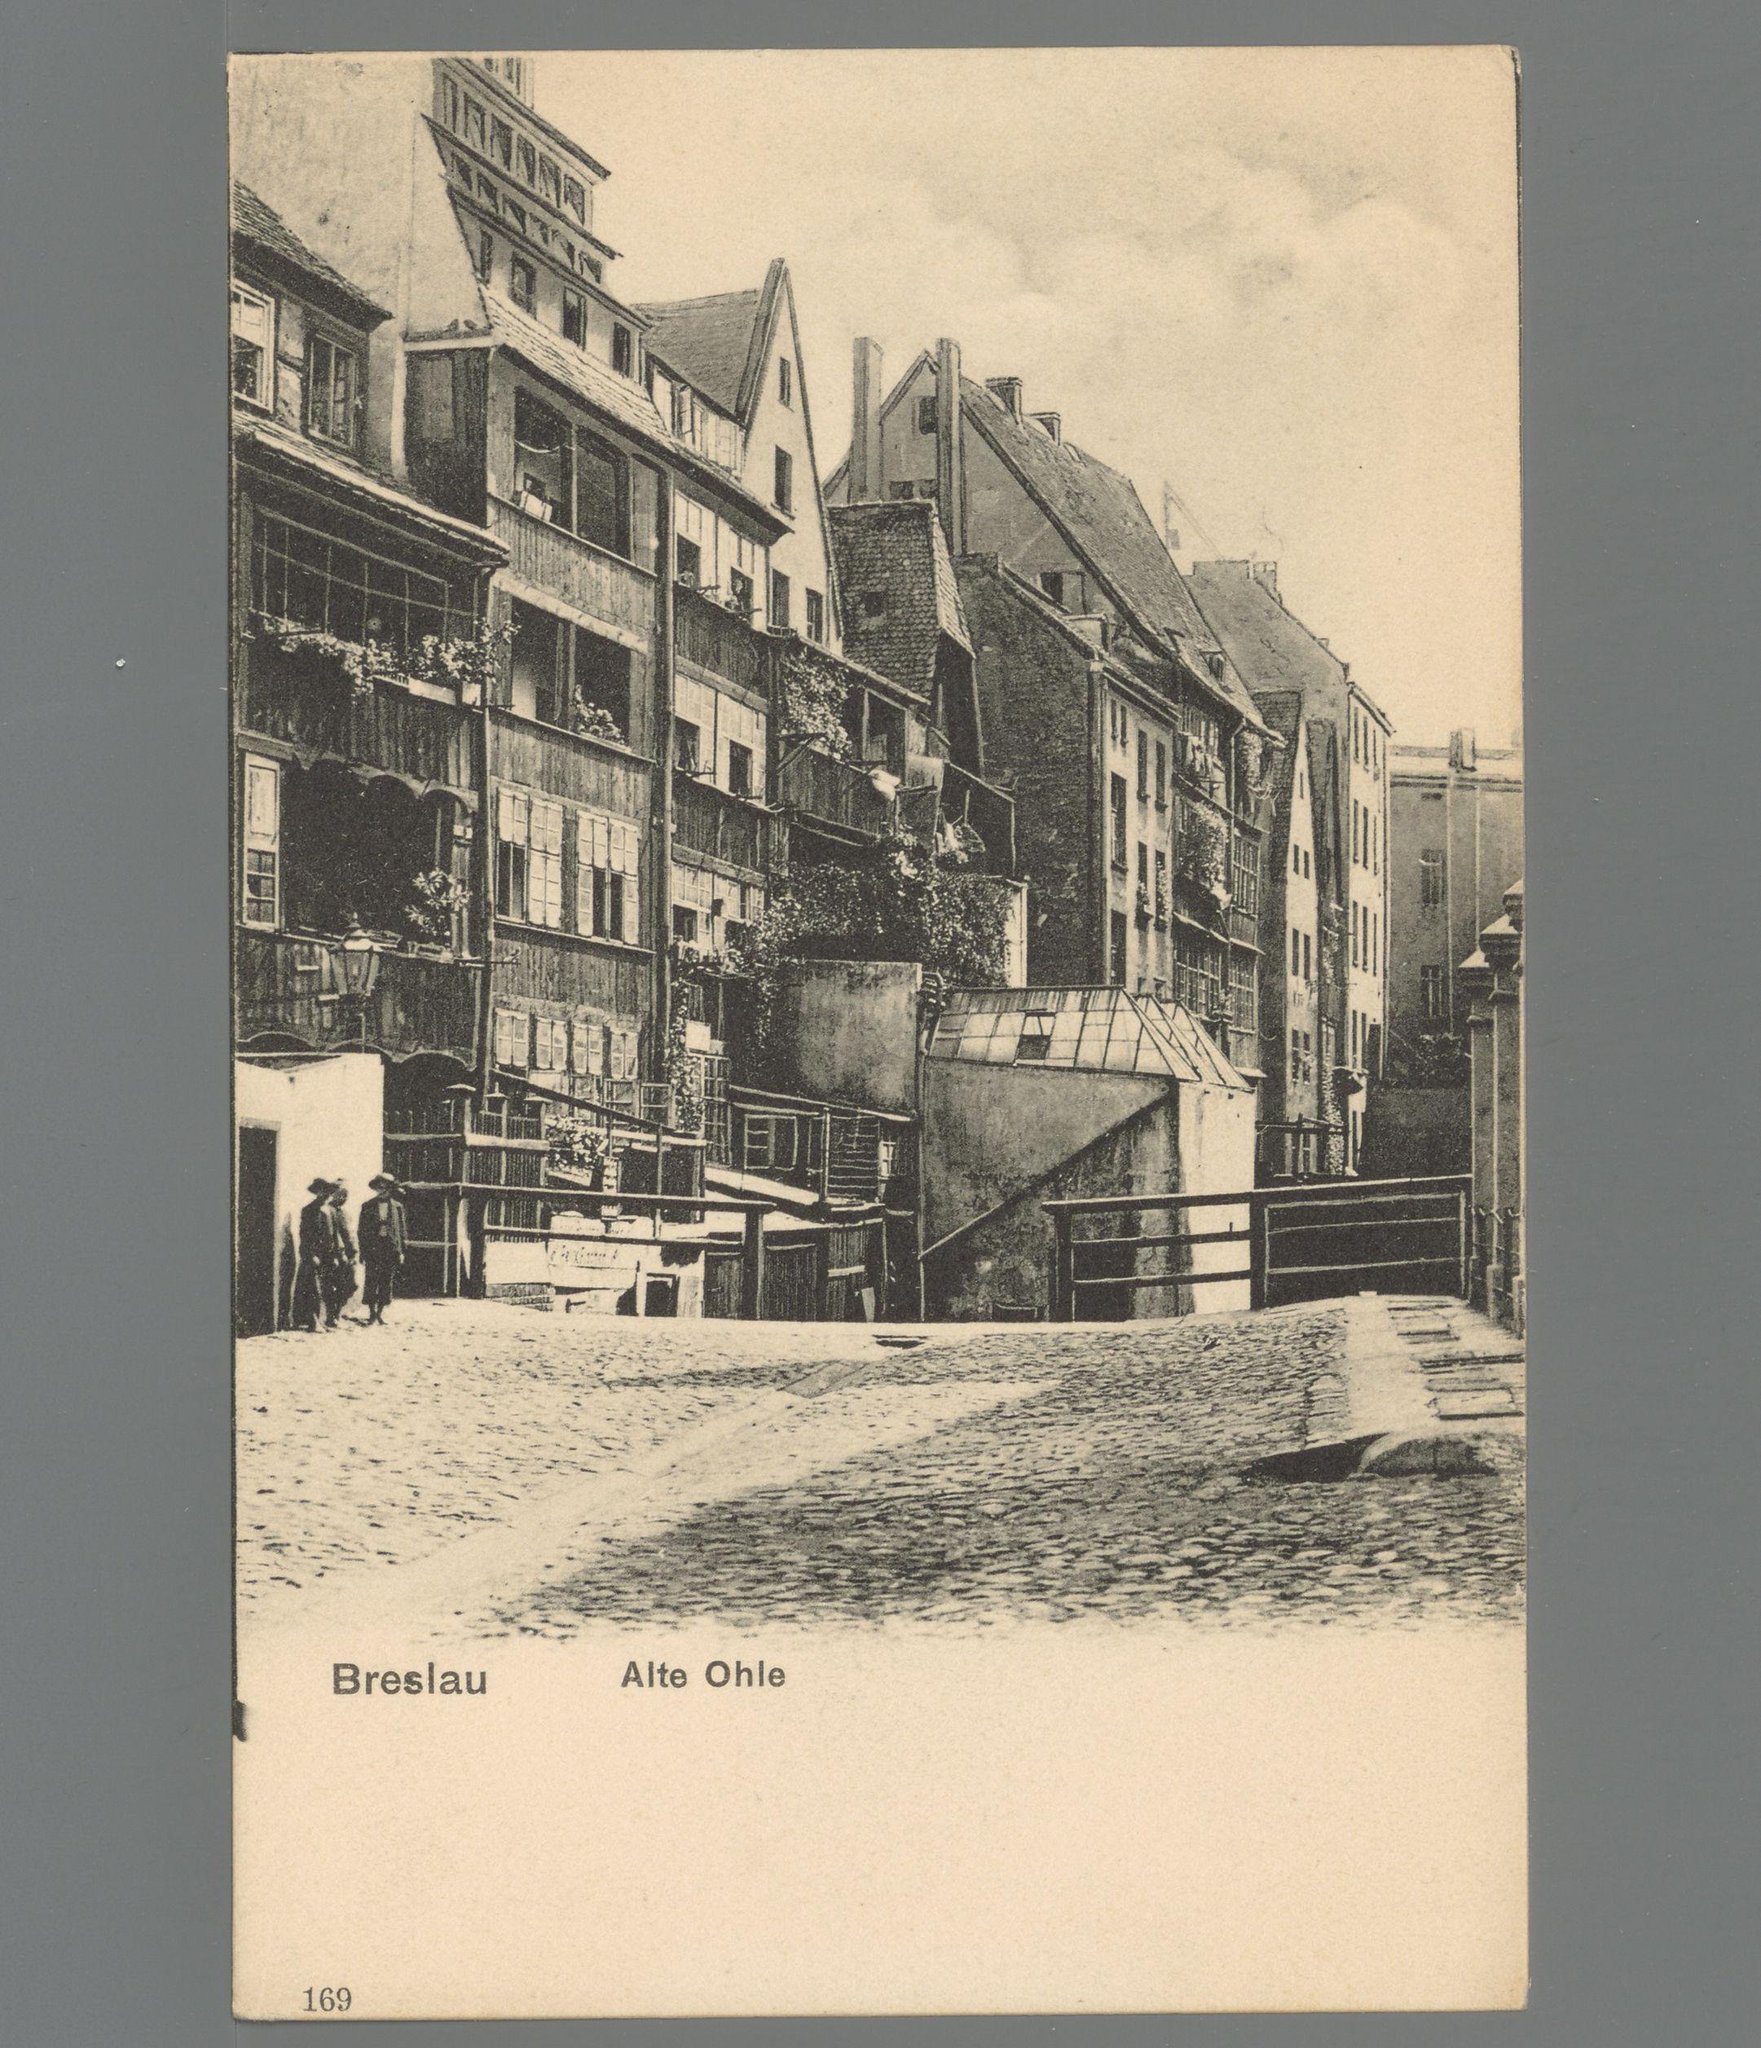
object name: ansichtkaart, prentbriefkaart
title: Breslau. Alte Ohle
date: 1905-1930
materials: cardboard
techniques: photograph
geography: breslau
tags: street